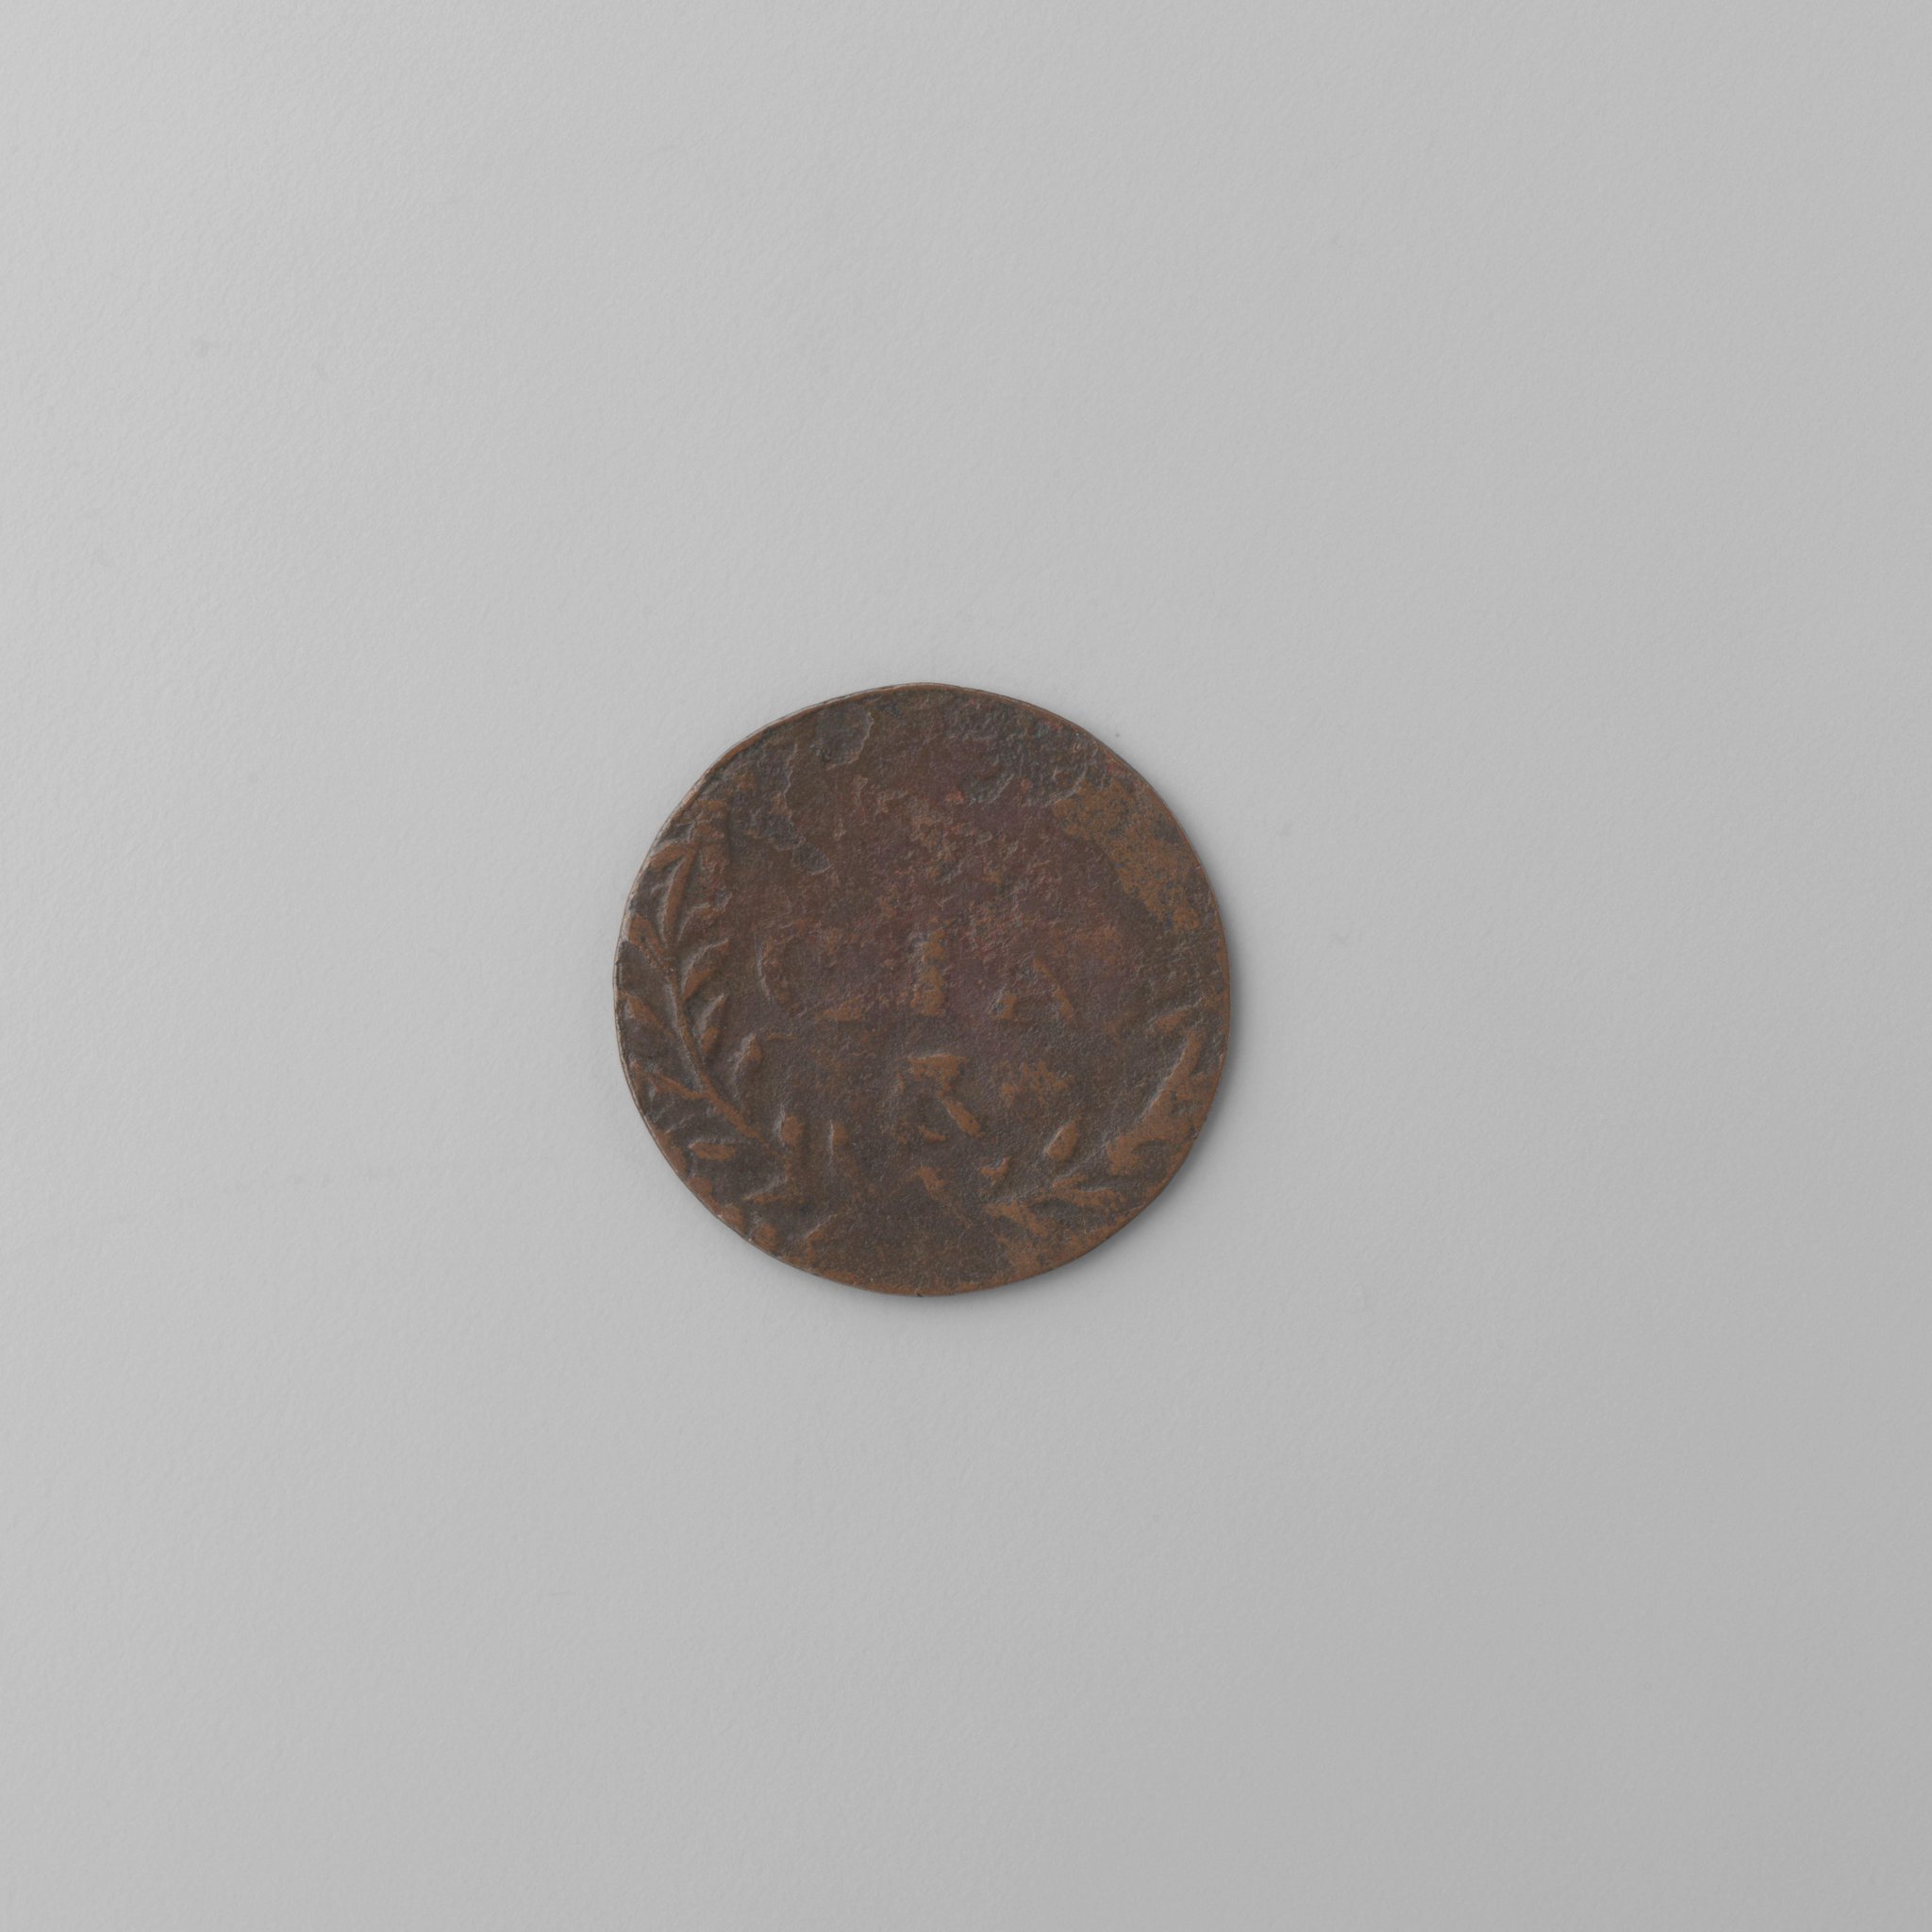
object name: coin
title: Reckheim, Francois Gobert en Ferdinand Gobert van Aspremont-Lynden (1665-1703), duit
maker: heer van reckheim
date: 1665-1703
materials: copper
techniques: striking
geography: rekem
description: Koperen munt. Voorzijde: door twee leeuwen gehouden gekroond wapenschild van Utrecht. Keerzijde: in een vierpas een-regelig opschrift.